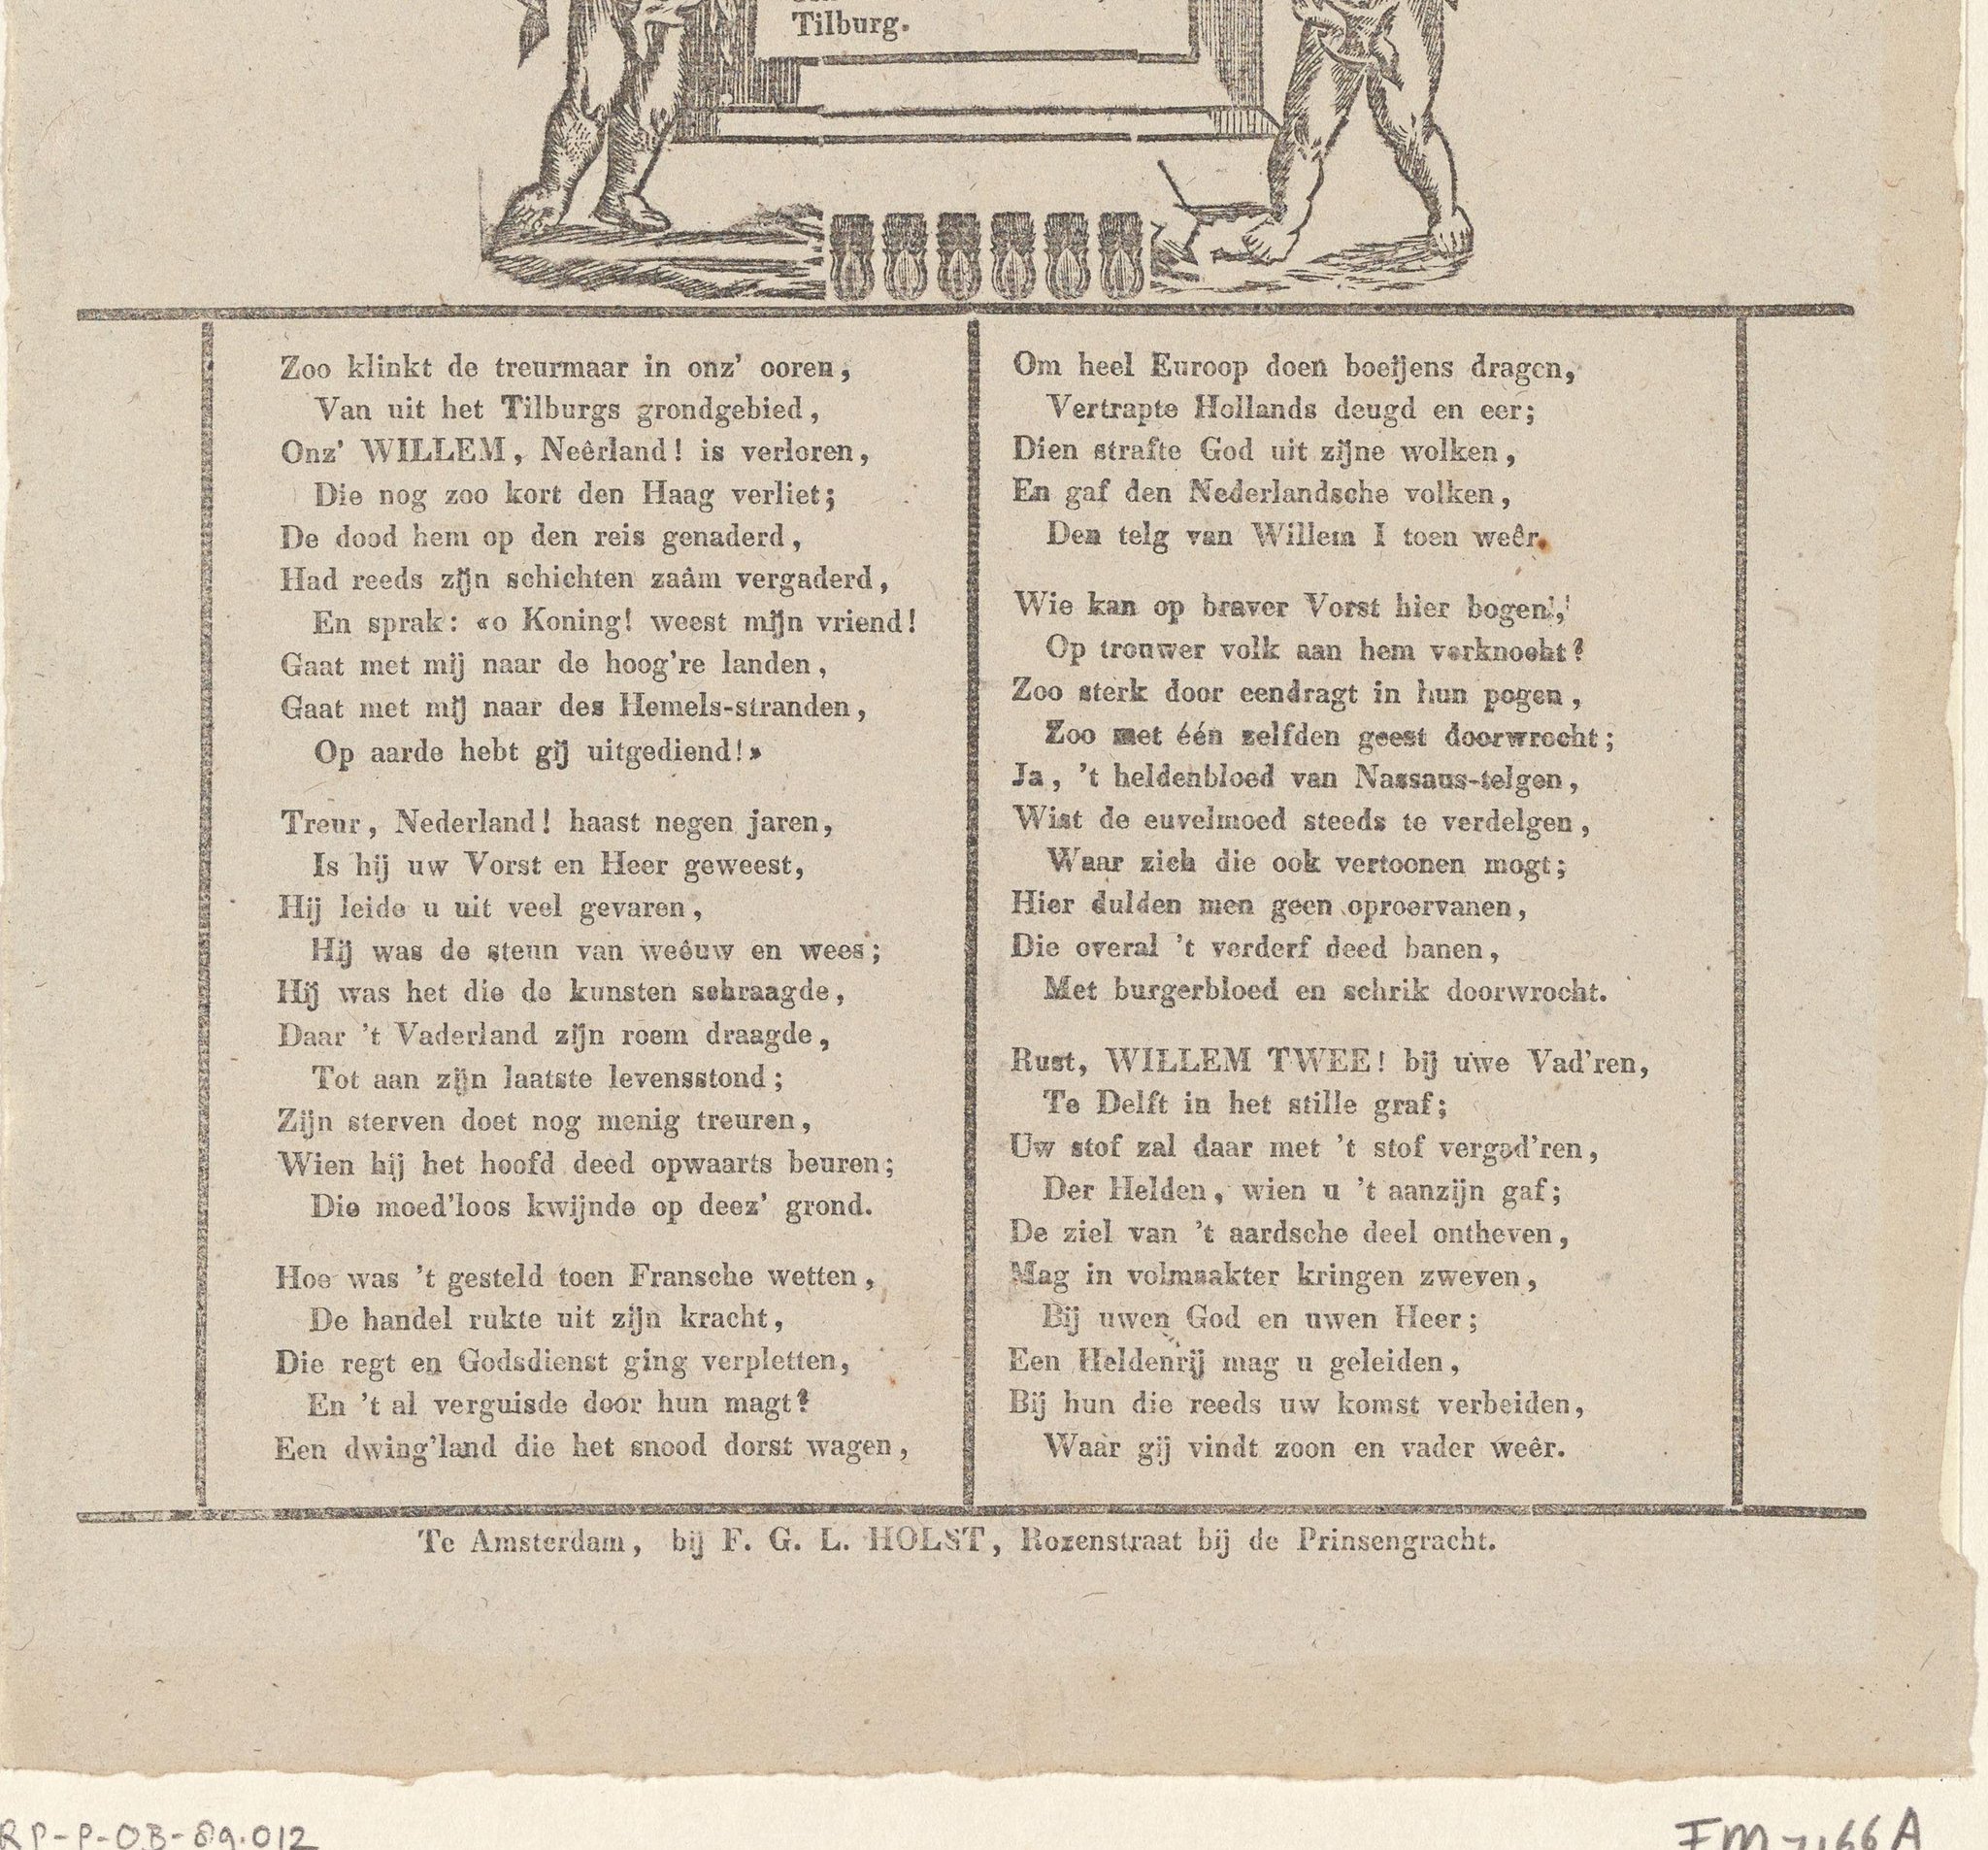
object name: poem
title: De Roem van Spanje. De Held van Waterloo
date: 1849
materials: paper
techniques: letterpress printing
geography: netherlands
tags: william ii of the netherlands, delft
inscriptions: collector's mark: Lugt 2228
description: Treurdicht op het overlijden van koning Willem II op 17 maart 1849 teTilburg en zijn begrafenis op 4 april 1849 te Delft. Vers in twee kolommen, bovenaan een allegorisch vignet met twee putti bij een grafmonument met afgebroken zuil.